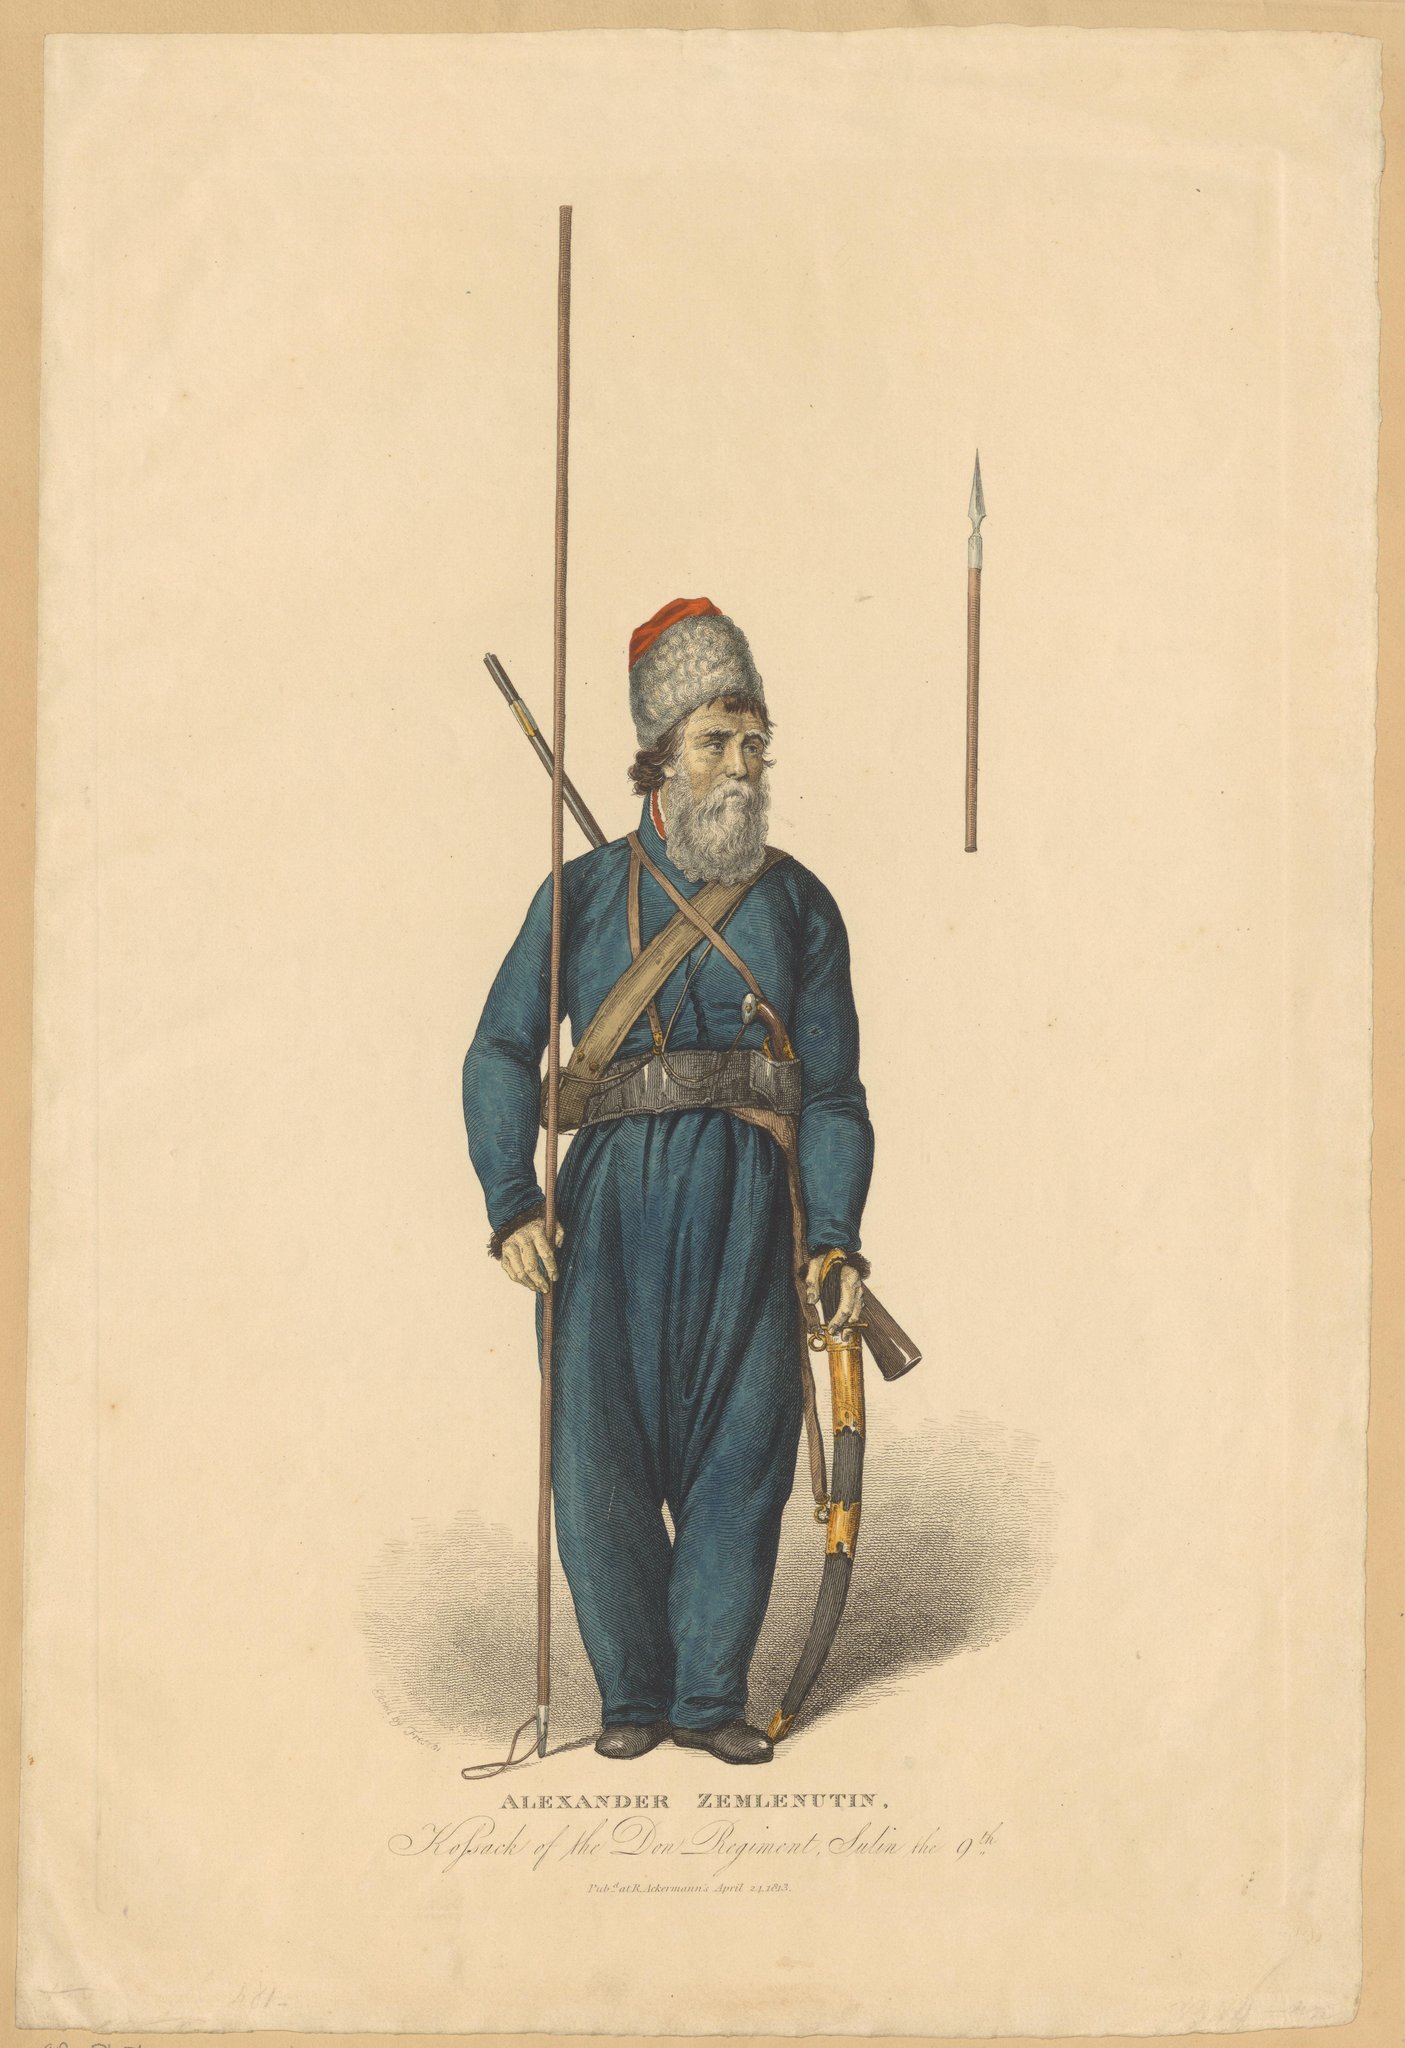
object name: print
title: Alexander Zemlenutin. Kossack of the Don Regiment, Sulin the 9th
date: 1813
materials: paper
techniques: etching, hand coloring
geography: london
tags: historical persons, officer